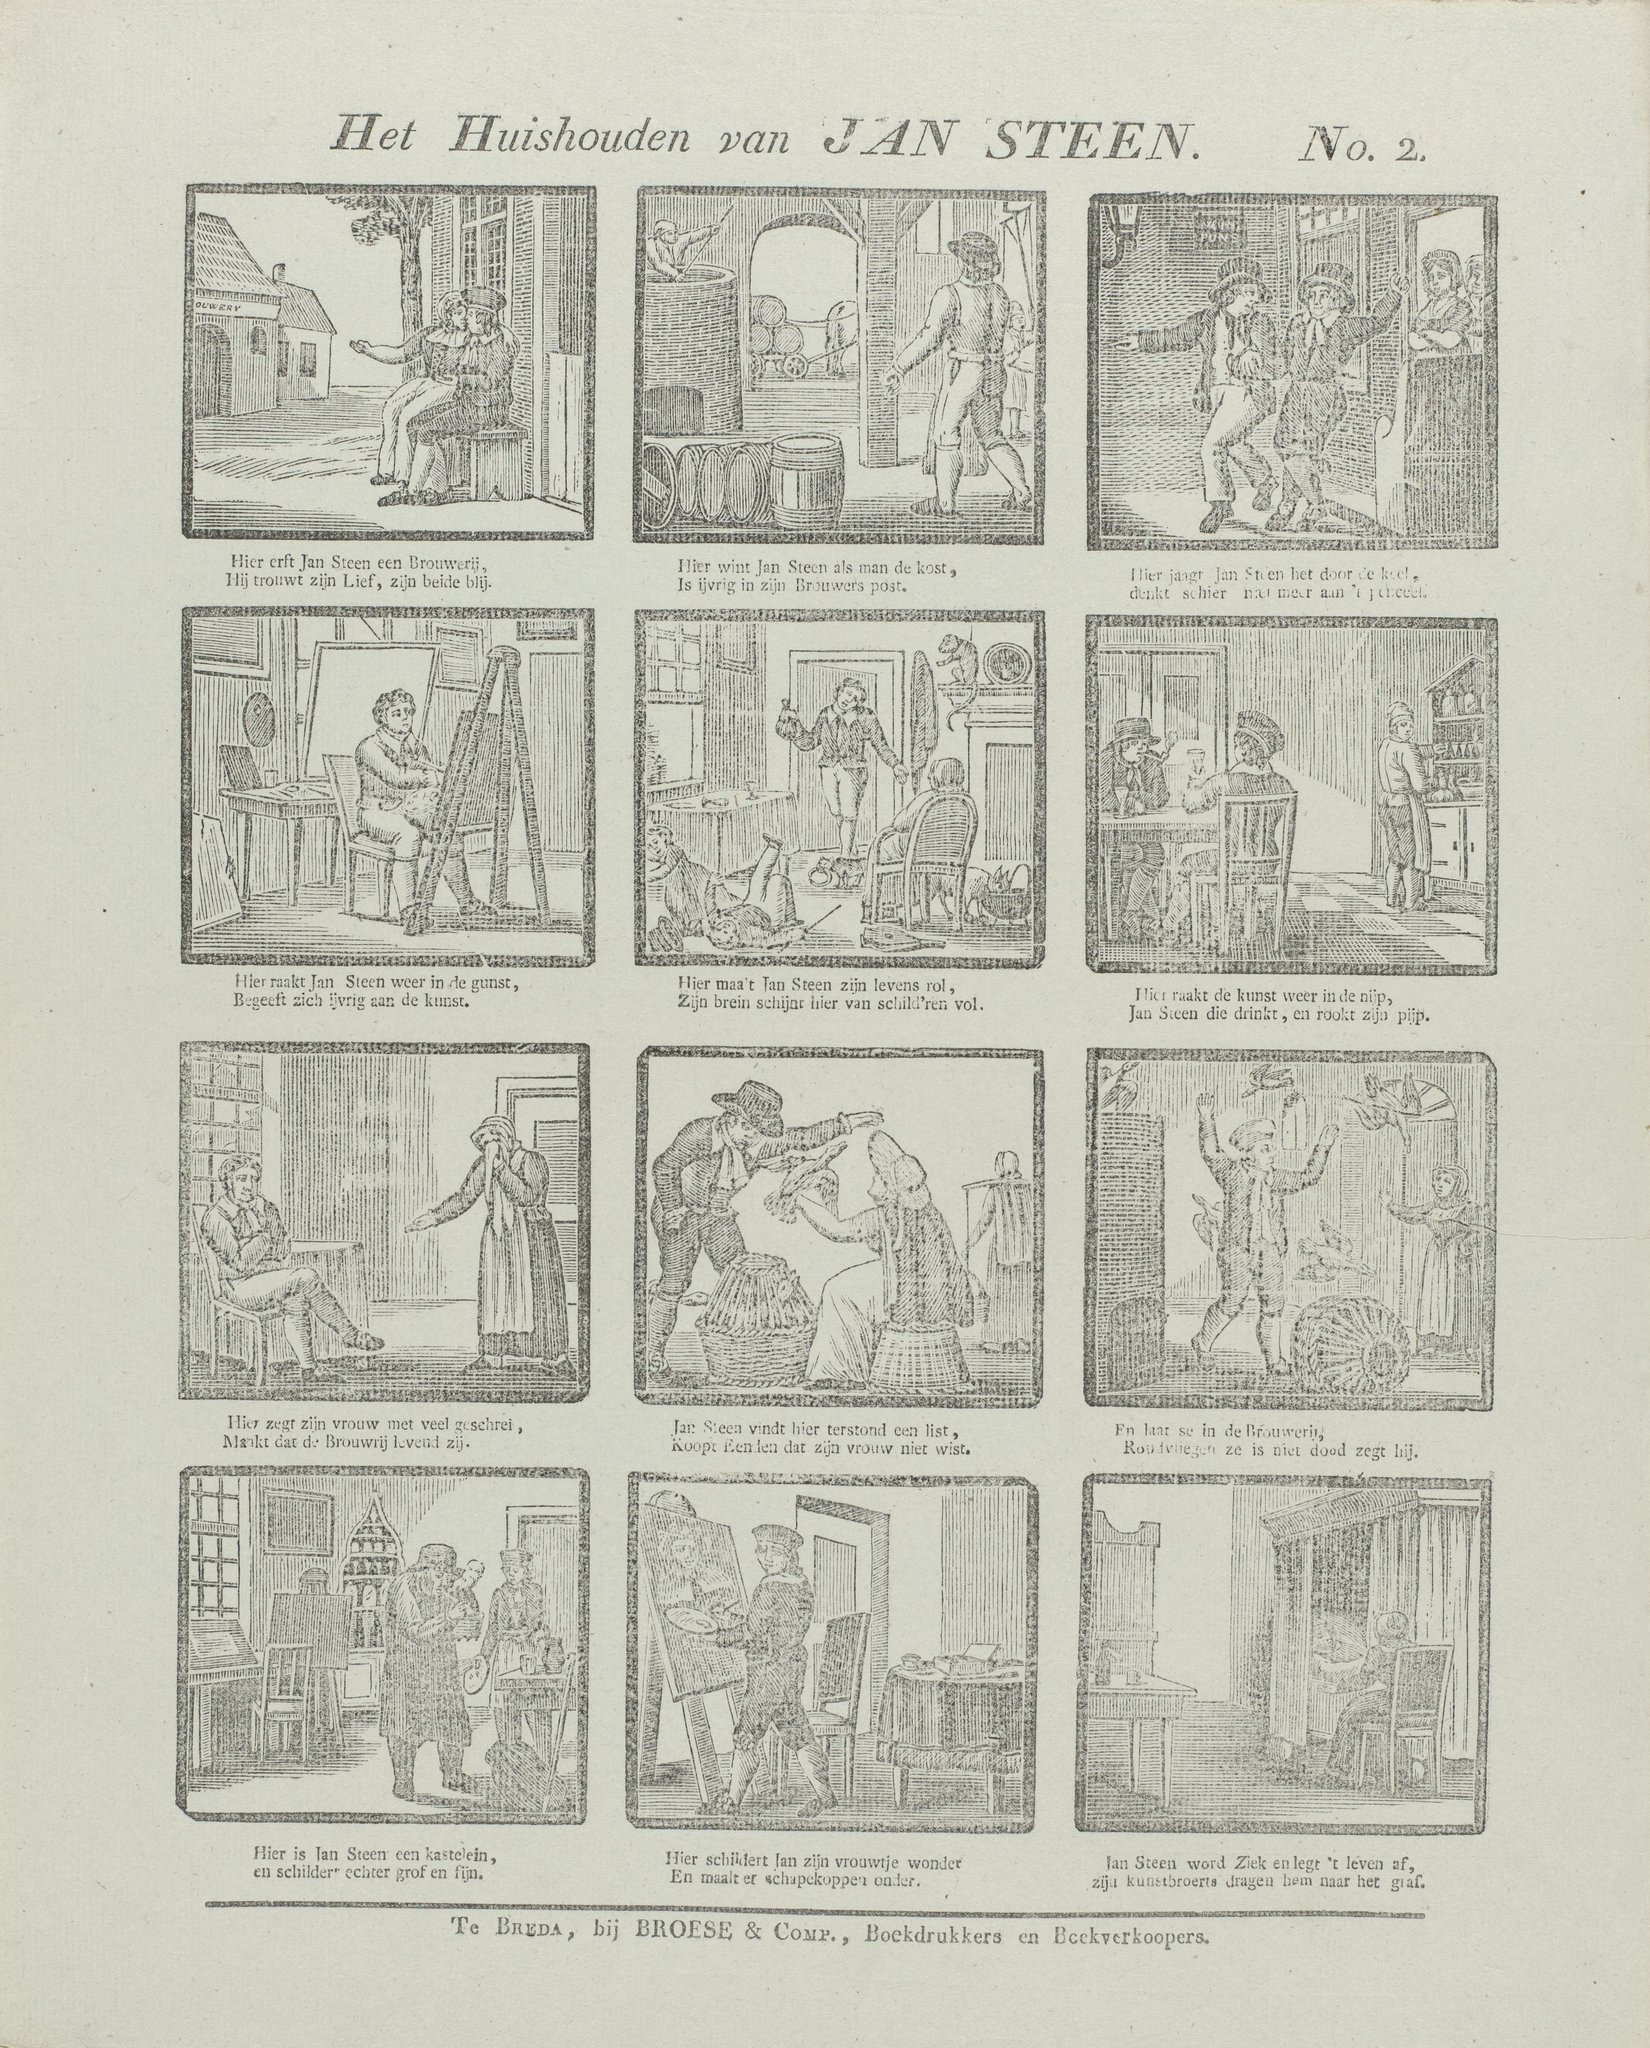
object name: print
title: Het huishouden van Jan Steen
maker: Anonymous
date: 1828-1853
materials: paper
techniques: letterpress printing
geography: breda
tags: a perfect shambles (dutch: 'huishouden van jan steen')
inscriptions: collector's mark: Lugt 2760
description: Blad met 12 voorstellingen uit het huishouden van Jan Steen. Jan schildert, heeft een brouwerij, koopt eenden en sterft. Onder elke voorstelling een tweeregelig vers. Genummerd rechtsboven: No. 2.